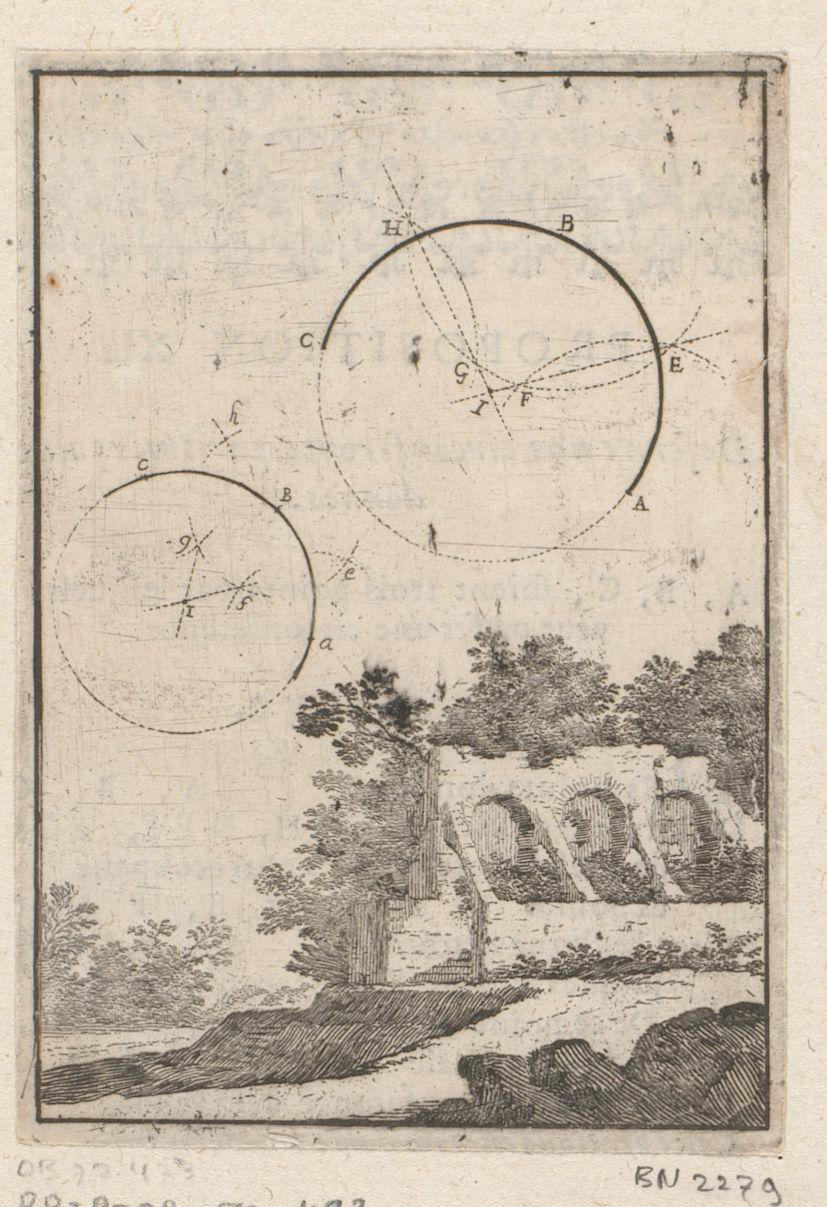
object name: print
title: Twee cirkels met onderaan een ruïne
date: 1669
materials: paper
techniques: etching, letterpress printing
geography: france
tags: landscape with ruins, circle (~ planimetry, geometry)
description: Prent uit: Pratique de la géometrie, sur le papier et sur le terrain. Avec un nouvel ordre et une méthode particulière. Parijs: Thomas Jolly, 1669.